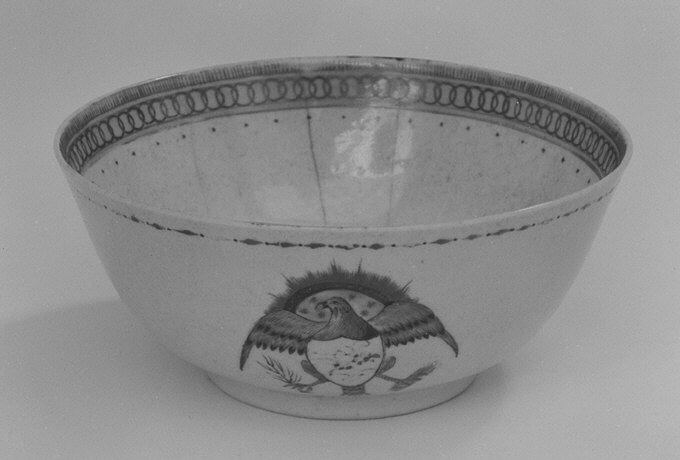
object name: bowl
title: Bowl (part of a service)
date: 1767-1833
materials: hard paste porcelain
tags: birds